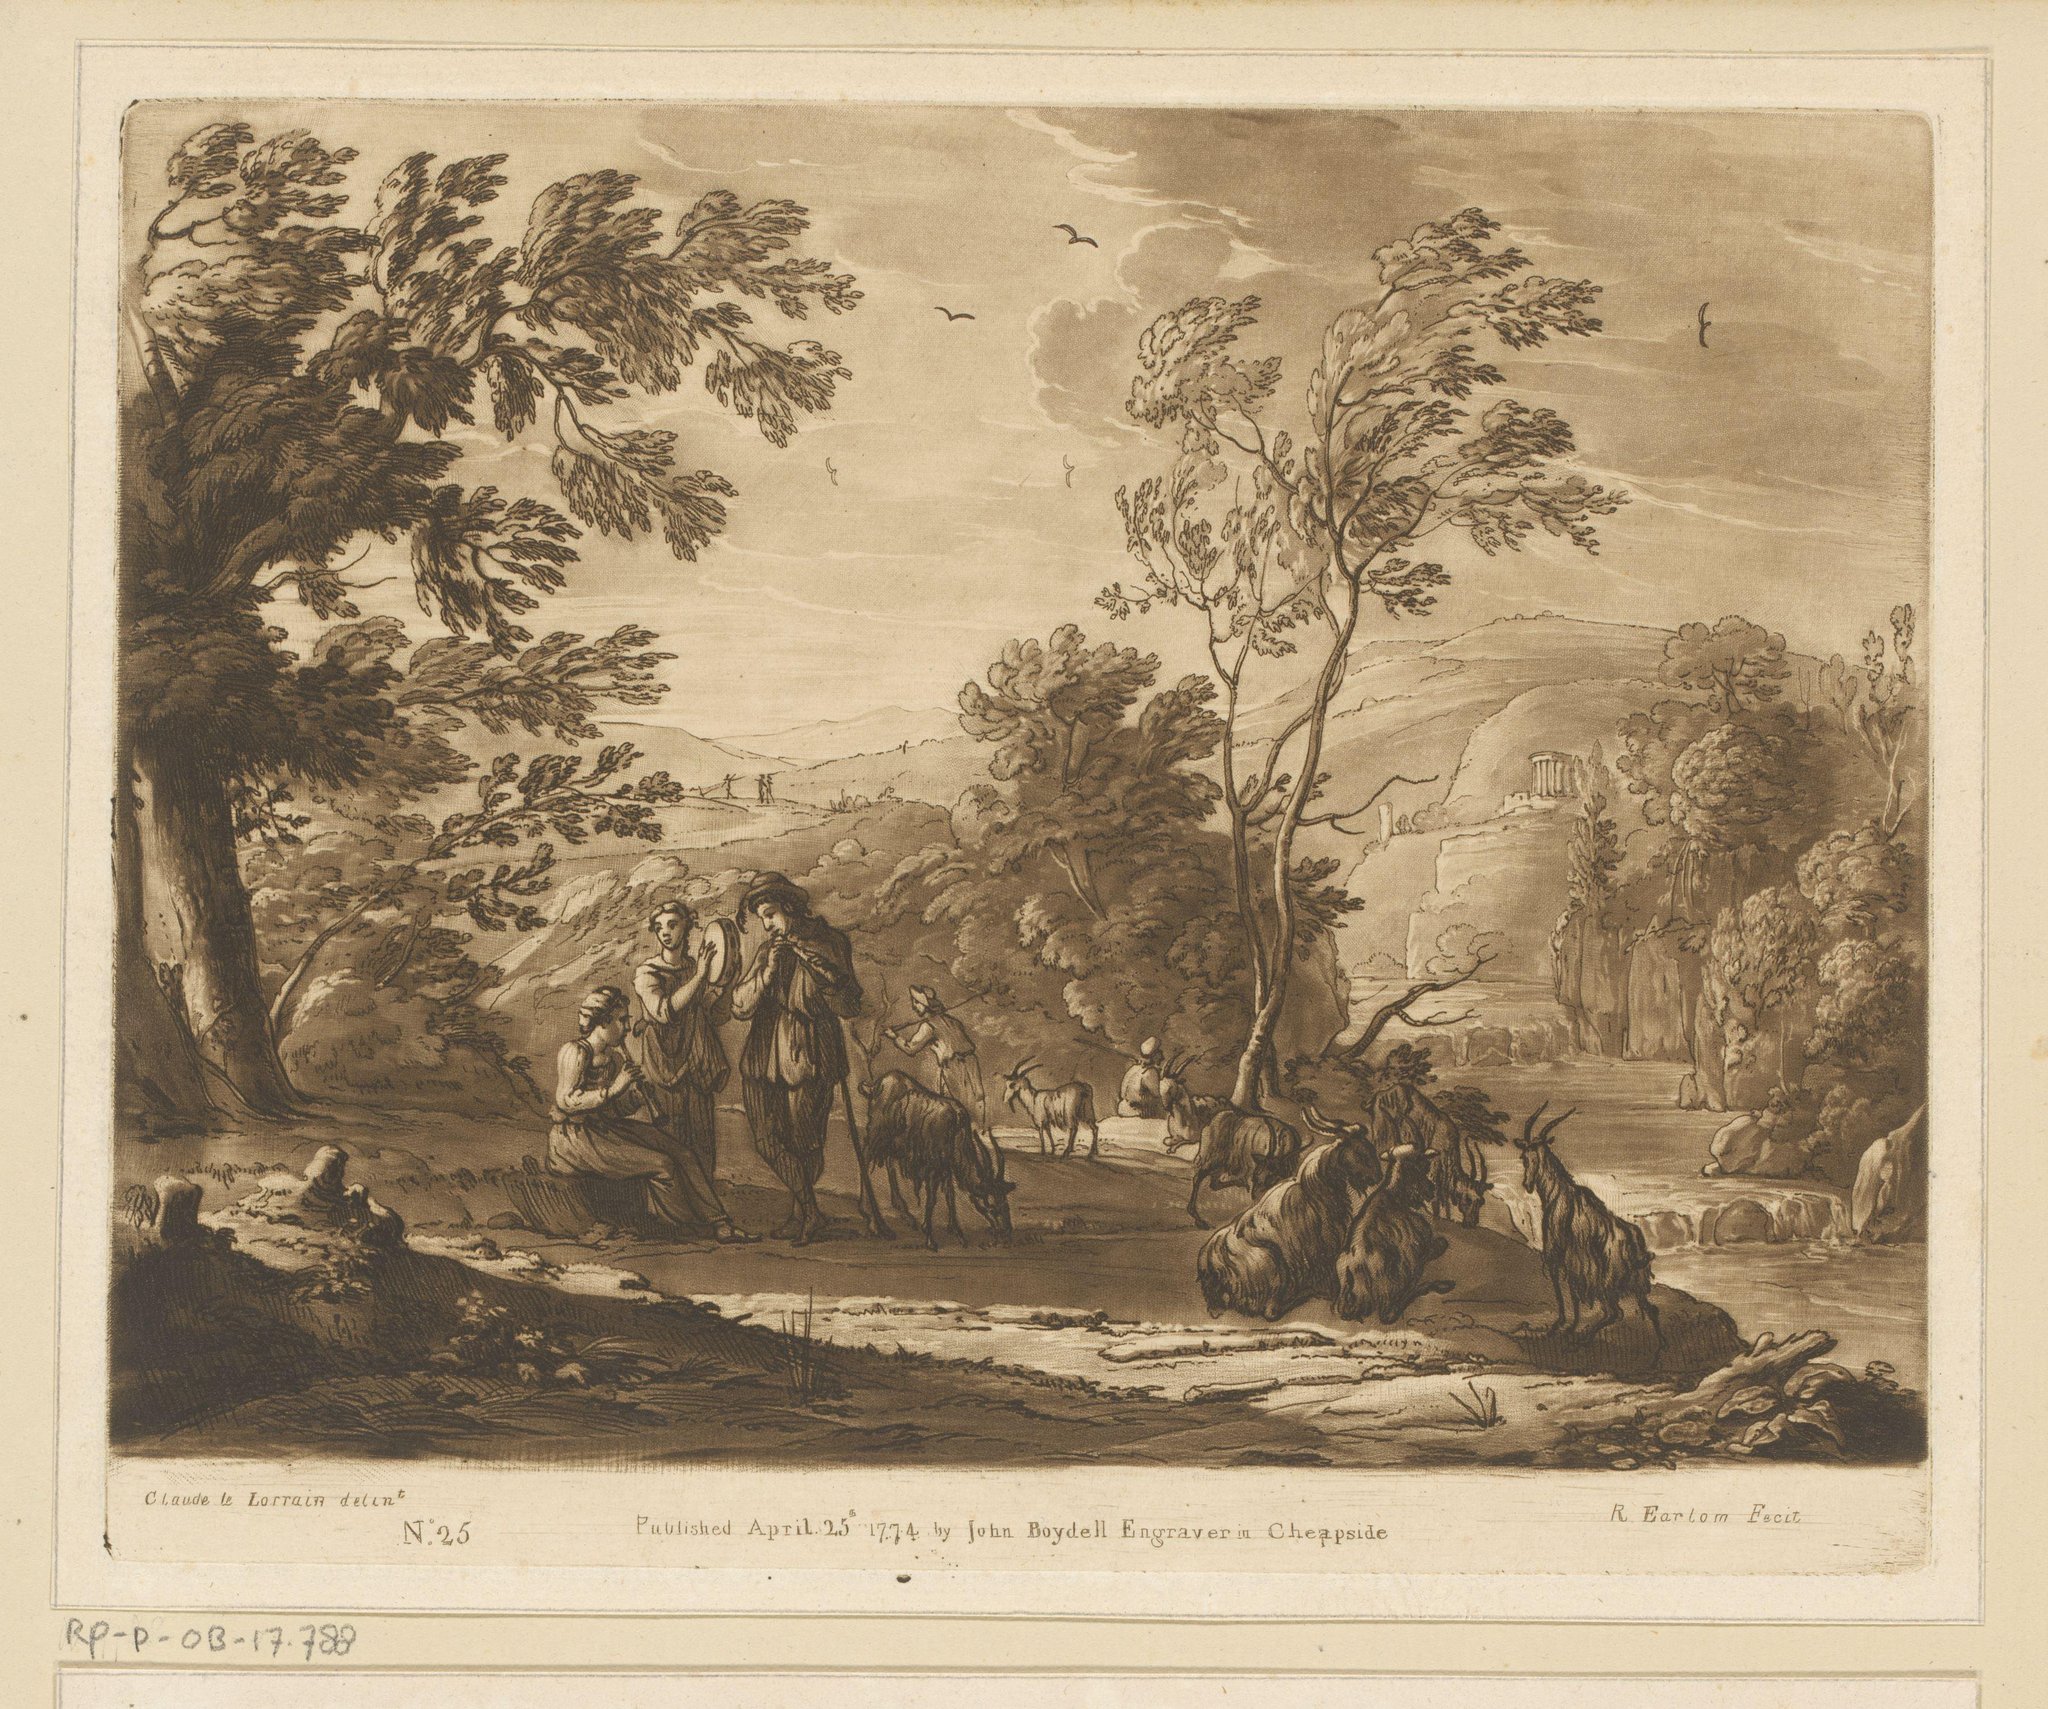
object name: print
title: Prenten naar tekeningen van Claude Lorrain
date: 1774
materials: paper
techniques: etching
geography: london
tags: river, cattle, making music; musician with instrument - cc - out of doors, pastorals, arcadian scenes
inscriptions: date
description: Vanaf 1774 publiceerde John Boydell tweehonderd prenten naar het tekeningenboek Liber Veritatis van Claude Lorrain, in het bezit van de hertogen van Cavendish. Deze prenten werden vanaf 1777 in twee volumes gebundeld uitgegeven.